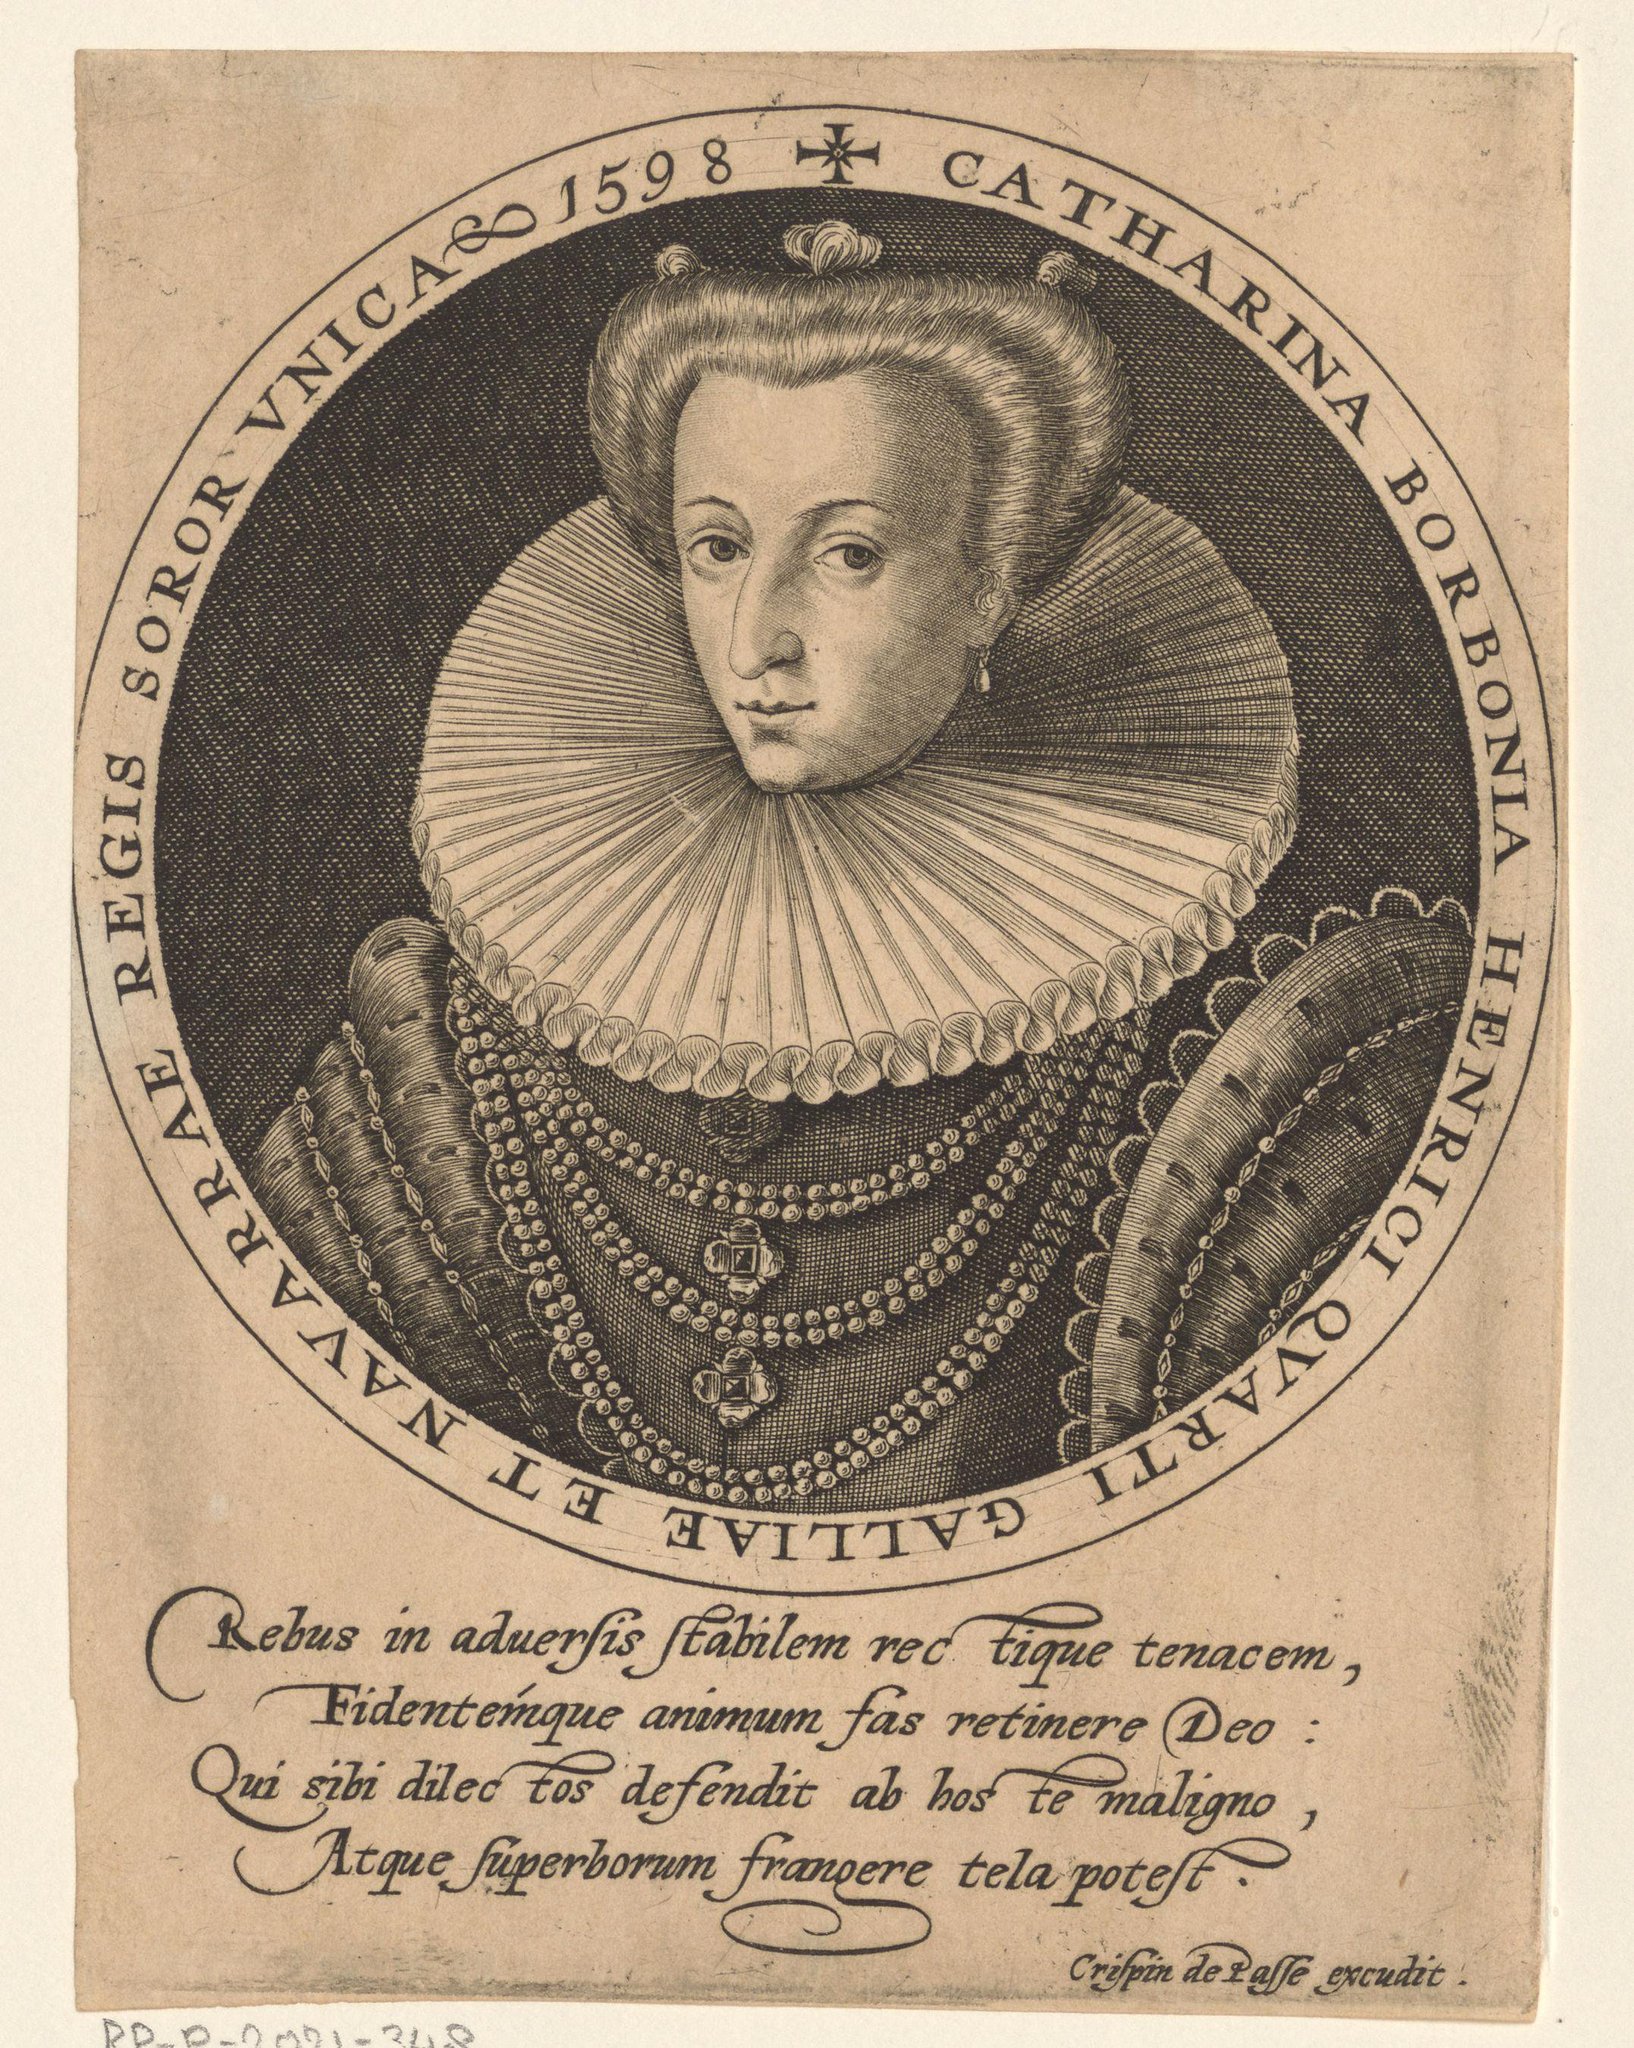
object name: print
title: Portret van Catharina de Bourbon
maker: crispijn van de passe (i)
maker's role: draughtsman, print maker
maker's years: 1564-1637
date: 1598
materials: paper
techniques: engraving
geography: utrecht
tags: historical persons - bb - woman, other sovereign - bb - female ruler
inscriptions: collector's mark: Lugt 2228